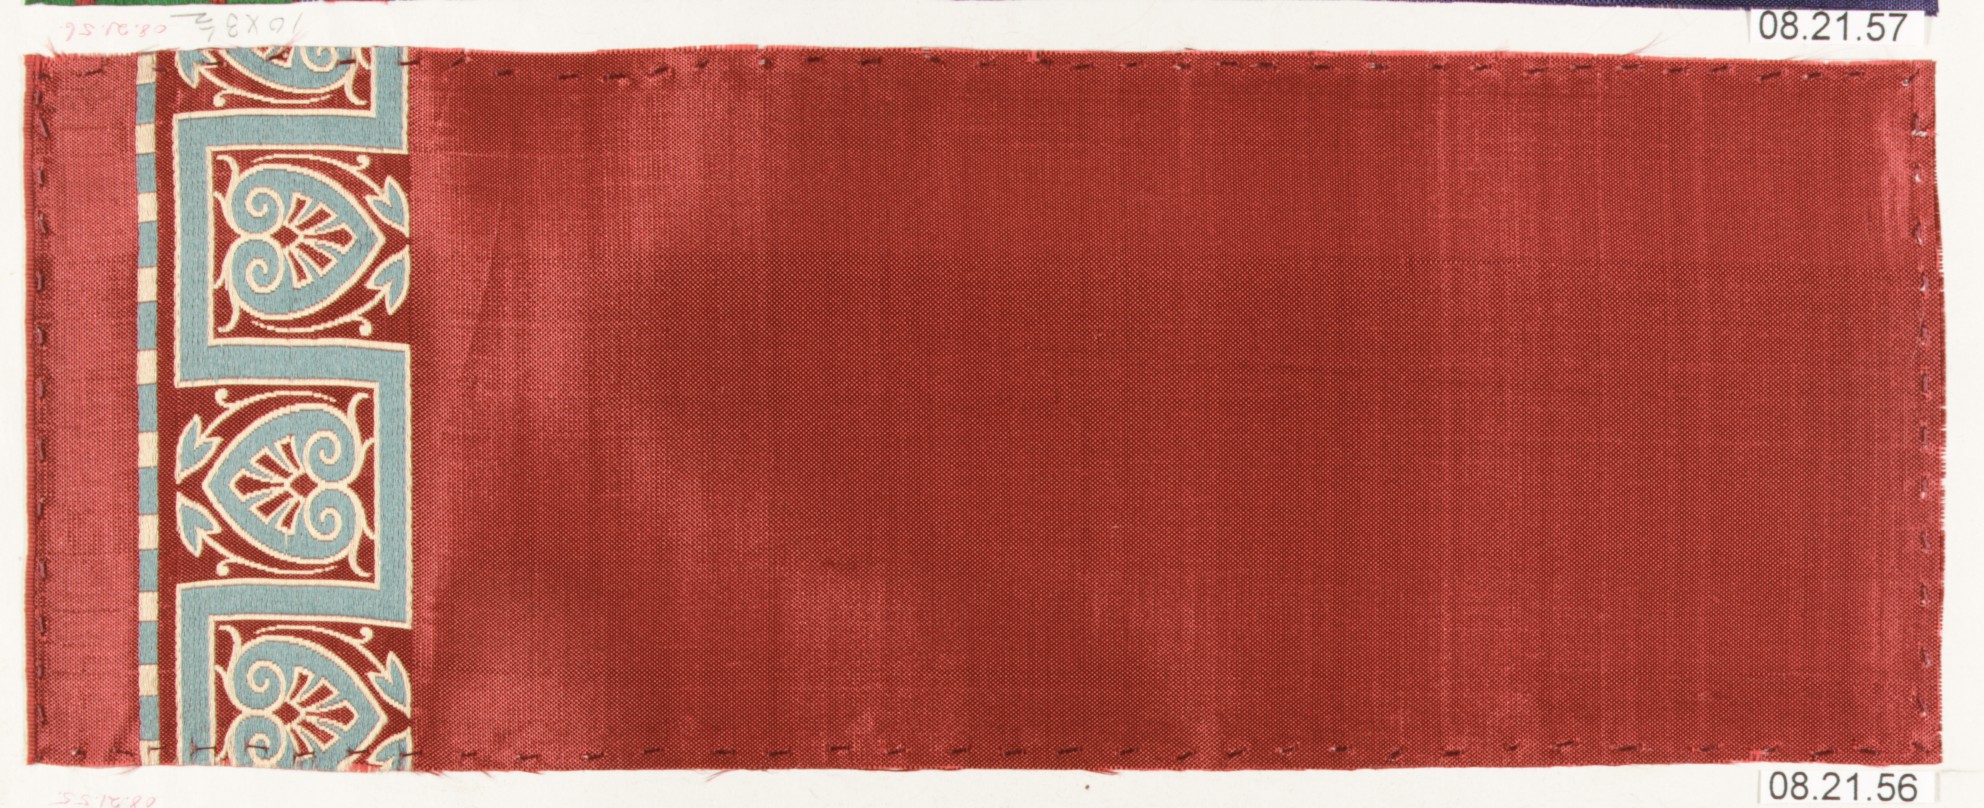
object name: textile sample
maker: Anonymous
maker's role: designer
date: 1900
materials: silk